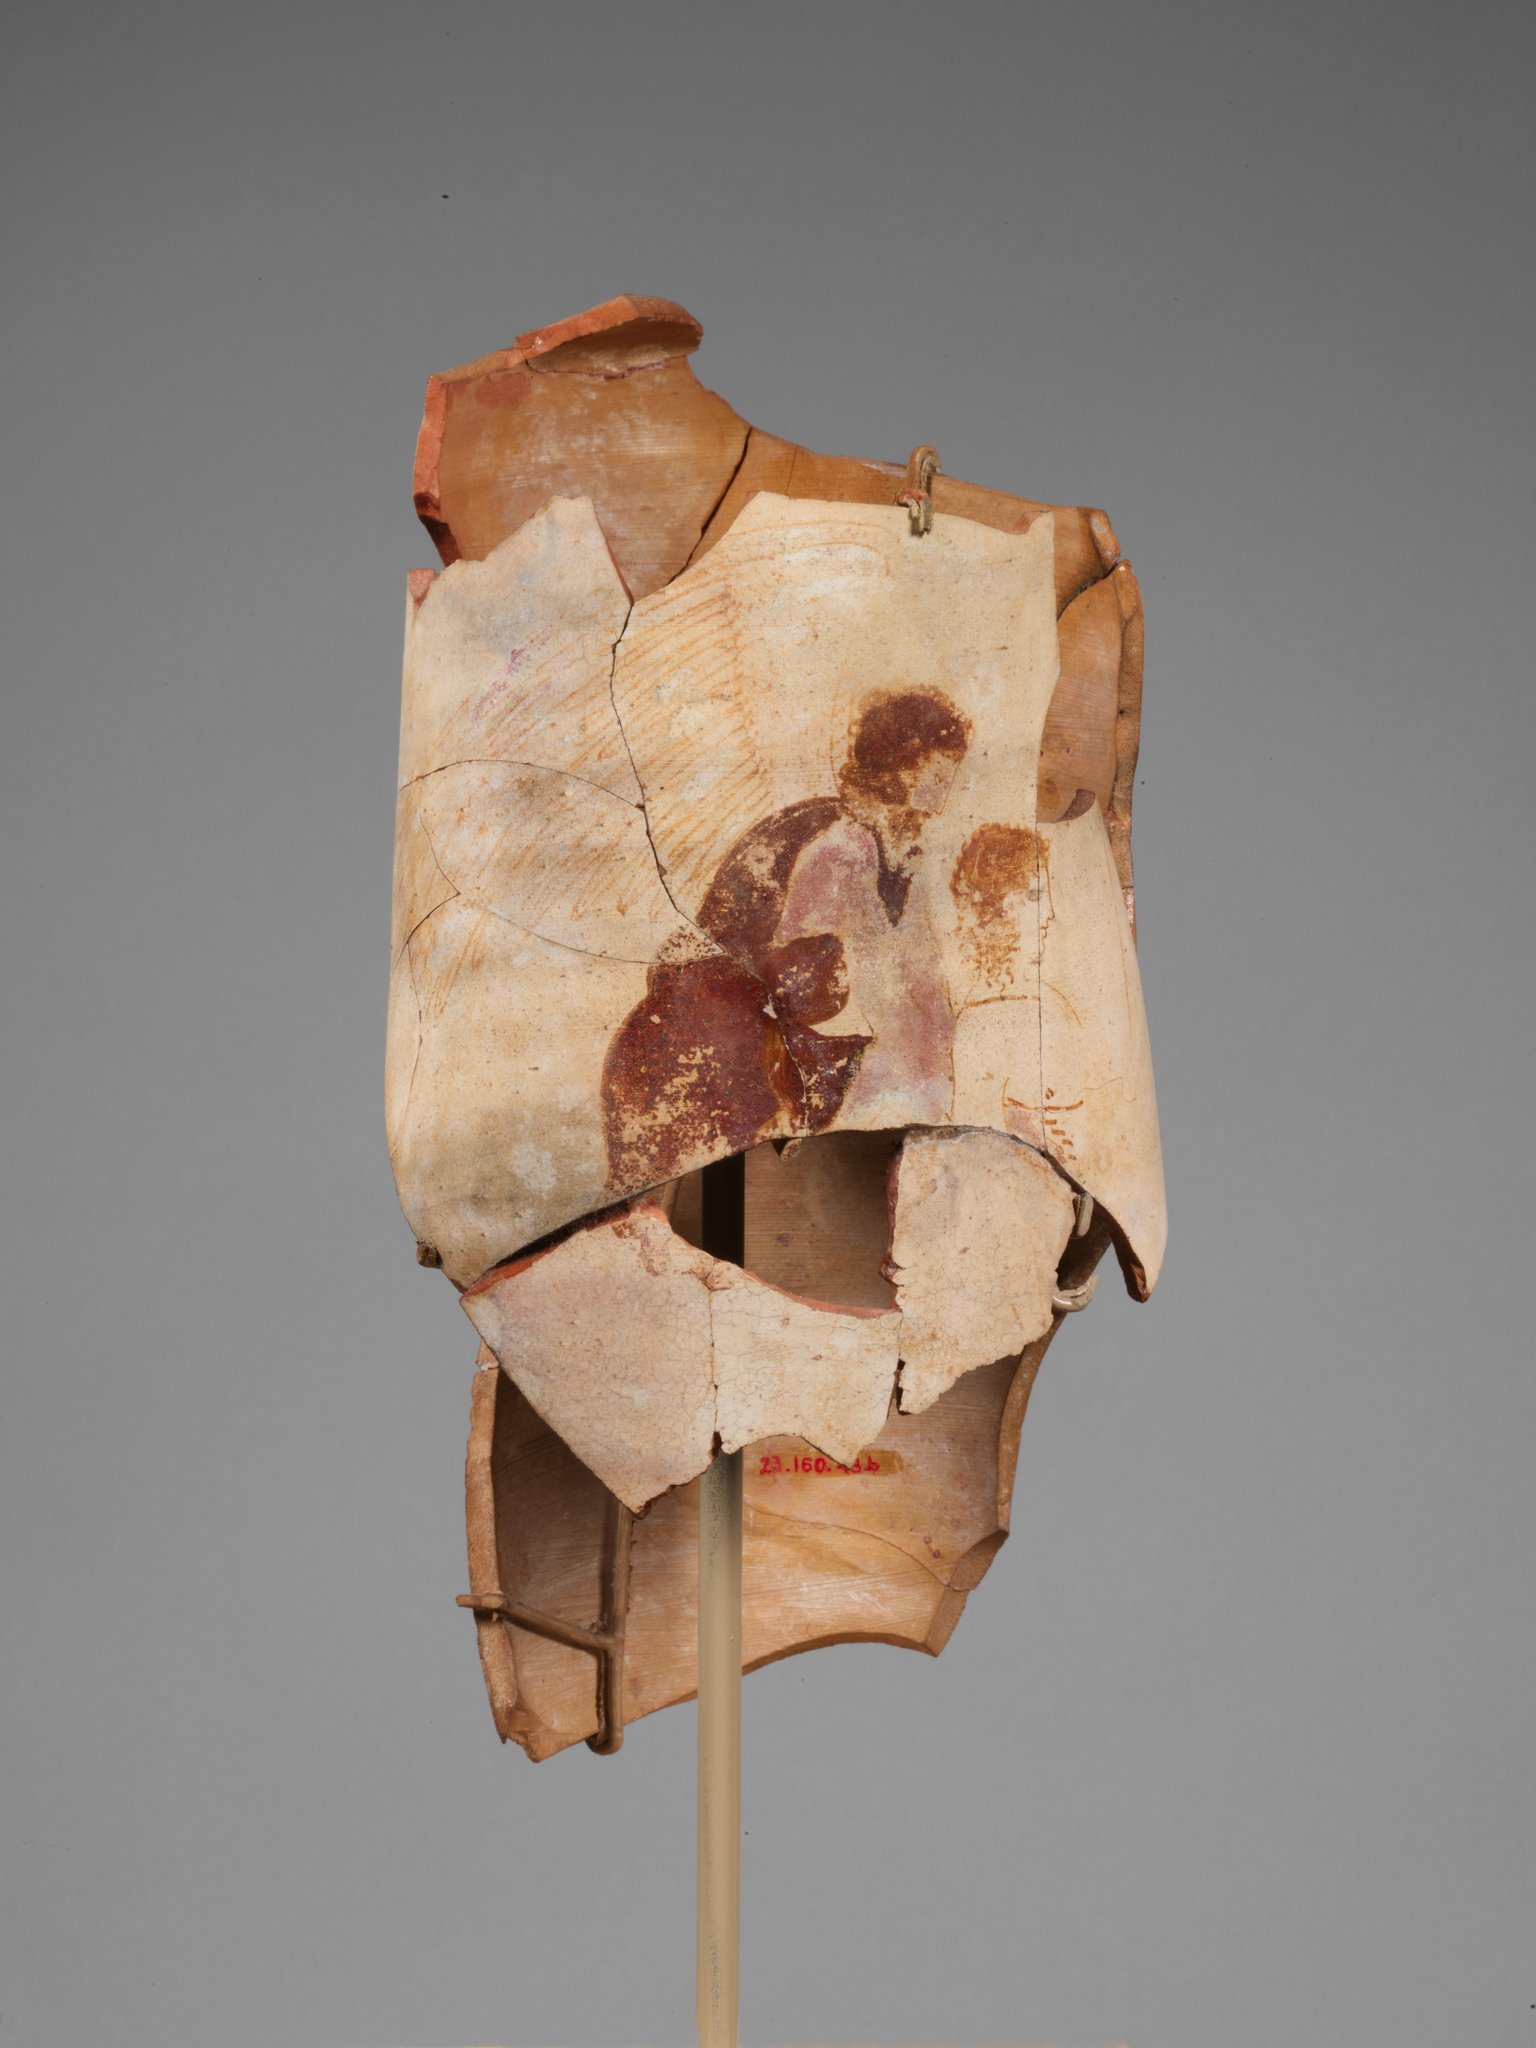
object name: lekythos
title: Terracotta lekythos (oil flask)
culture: greek, attic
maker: painter of the new york hypnos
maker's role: artist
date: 440-430 BCE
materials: terracotta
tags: men